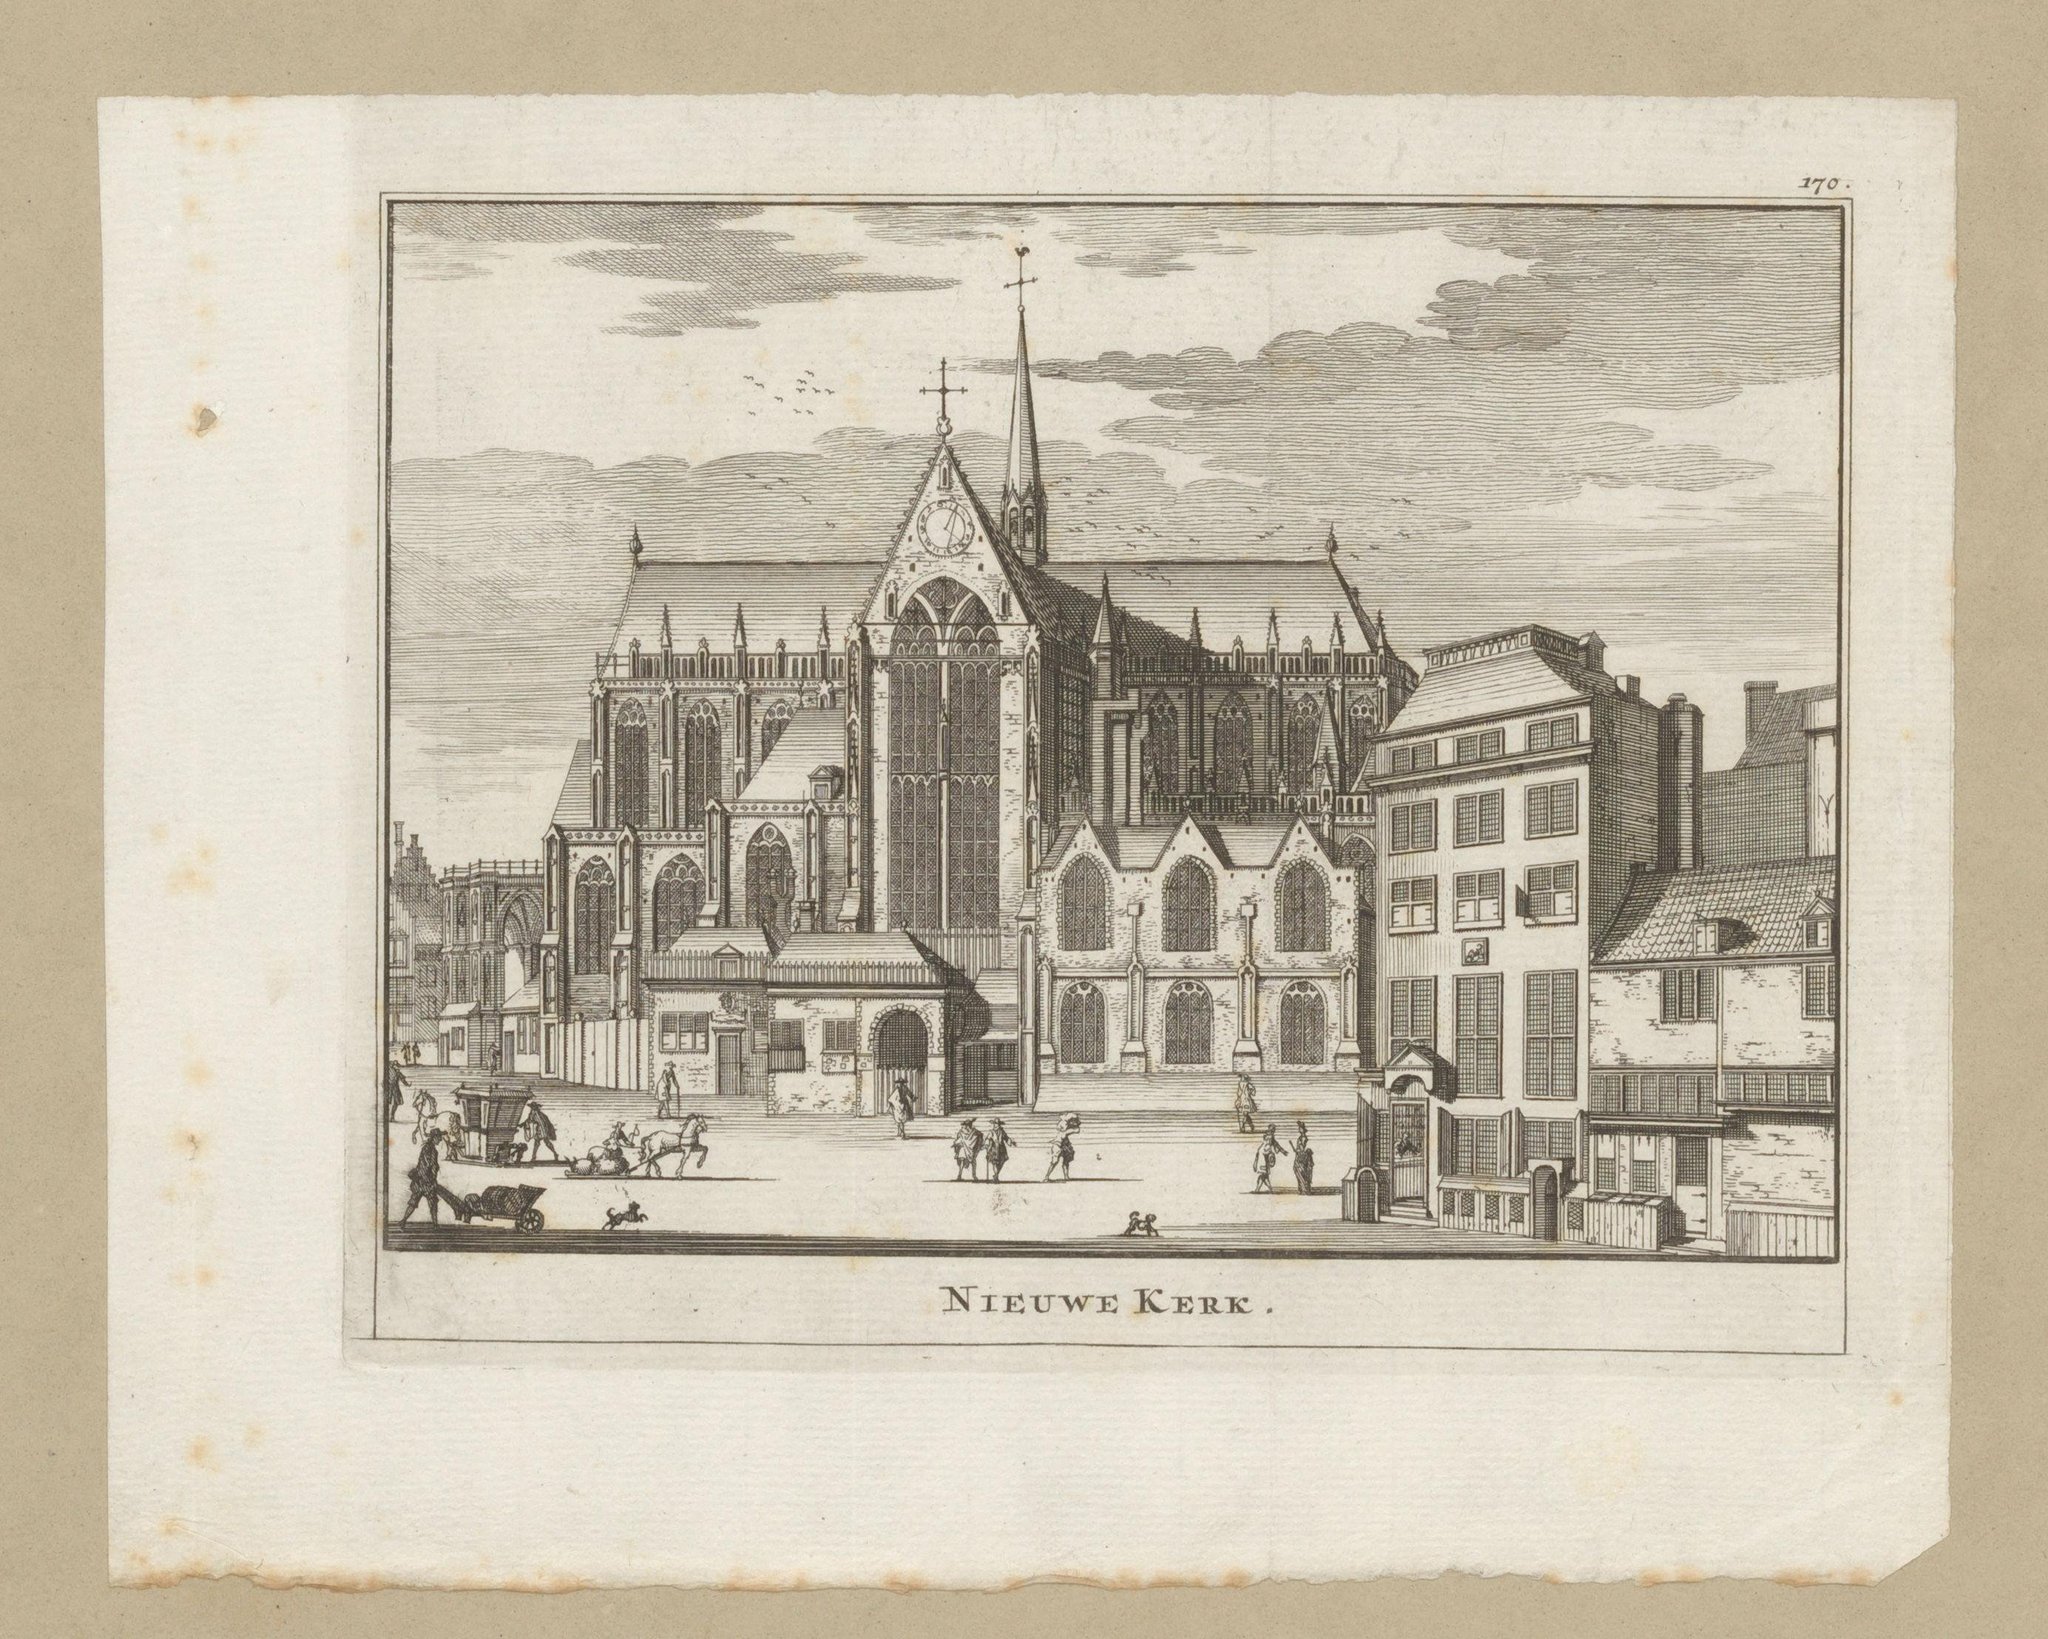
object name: print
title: Nieuwe Kerk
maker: Anonymous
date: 1726-1751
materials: paper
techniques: engraving, etching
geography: northern netherlands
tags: church (exterior), square, place, circus, etc. (+ city(-scape) with figures, staffage)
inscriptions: collector's mark: Lugt 1641b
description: Prent mogelijk uit: Hoorn, Nicolaas ten. Wegwyzer door Amsterdam zynde eene beknopte verhandeling van desselfs eerste opkomst, vergrootingen, en teegenwoordigen staat (...). Amsterdam: Nicolaas ten Hoorn, 1726. Of uit: Hoorn, Nicolaas ten. Wegwyzer, of korte beschryvinge van de stadt Amsterdam, zynde eene beknopte verhandeling van desselfs eerste opkomst, vergrootingen, en teegenwoordigen staat (...). Amsterdam: erven J. Ratelband & Co, 1737. Of uit: Hoorn, Nicolaas ten. Wegwyzer of korte beschryvinge der stad Amsterdam, zynde eene beknopte verhandeling van derzelver eerste opkomst, vergrootingen, en tegenwoordigen staat (...). Amsterdam: Pieter Meyer, 1751. Eerste staat van prent, genummerd 159, gebruikt in: Hoorn, Nicolaas ten. Wegwyzer door Amsterdam zynde eene beknopte verhandeling van desselfs eerste opkomst, vergrootingen, en teegenwoordigen staat (...). Amsterdam: Nicolaas ten Hoorn, 1713. En in: Hoorn, Nicolaas ten. Wegwyzer door Amsterdam zynde eene beknopte verhandeling van desselfs eerste opkomst, vergrootingen, en teegenwoordigen staat (...). Amsterdam: Nicolaas ten Hoorn, 1726. Derde staat van prent ongenummerd, zie KOG-AA-1-30-68A.